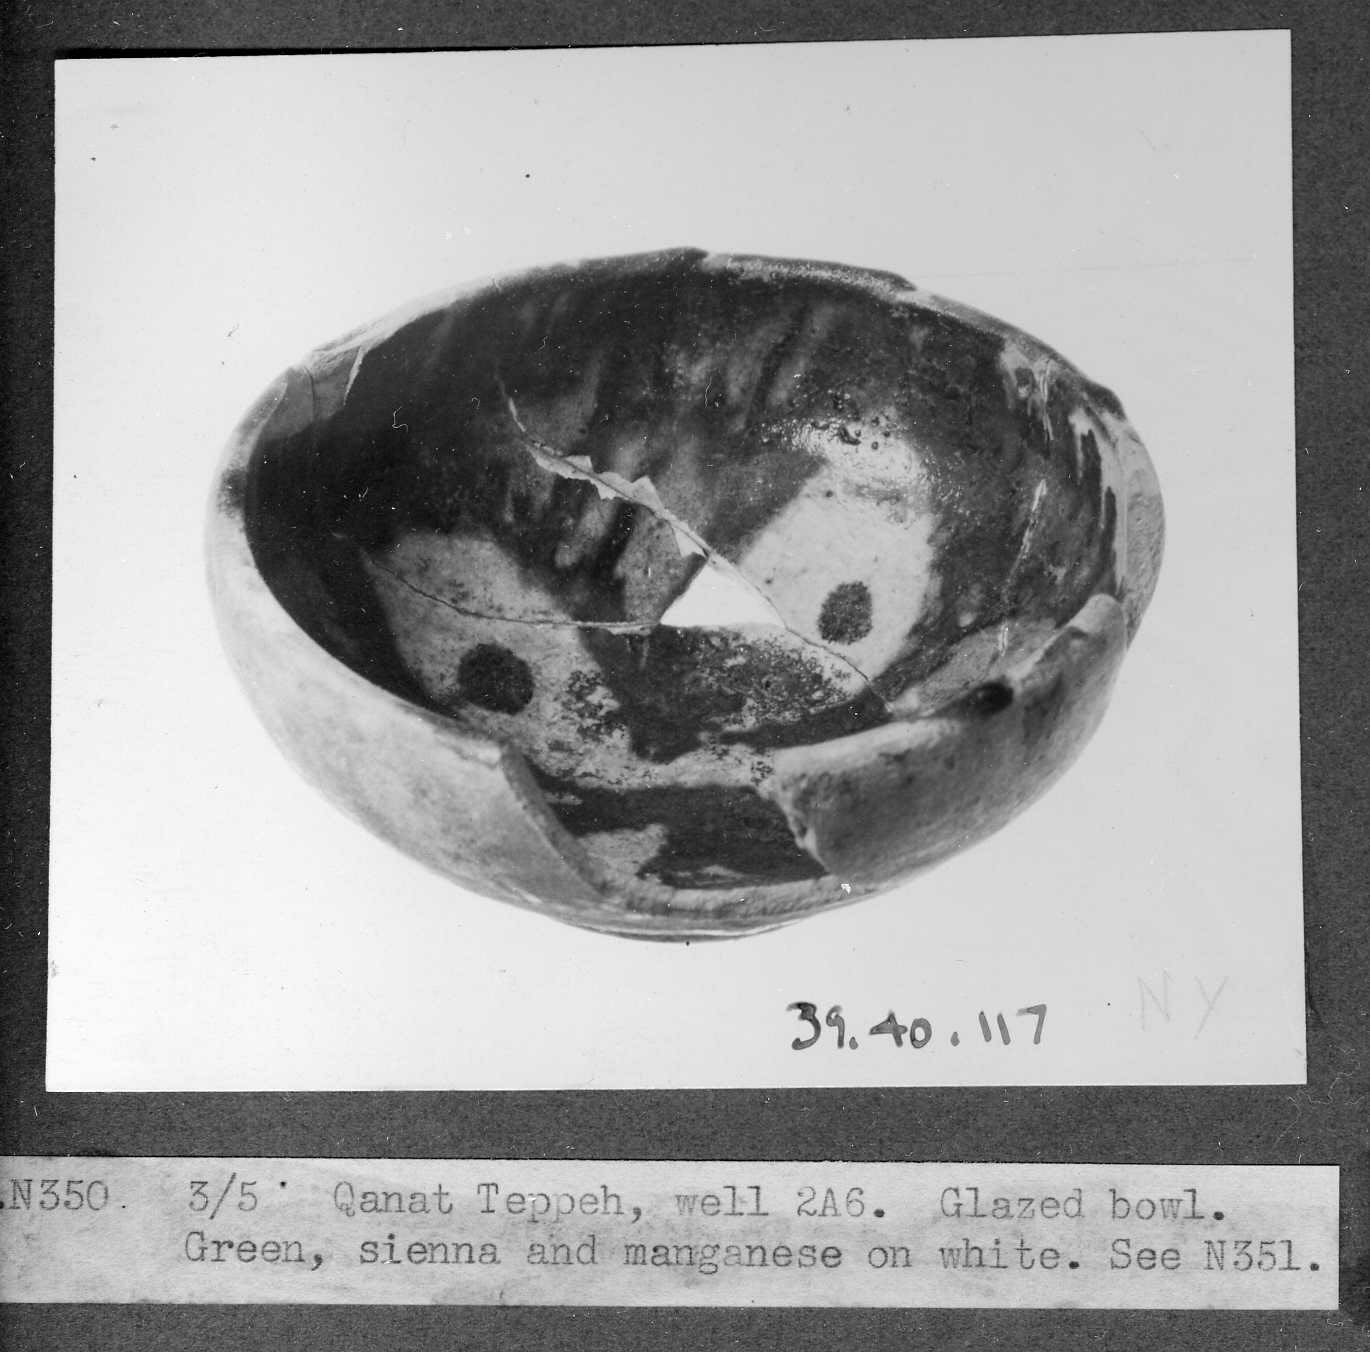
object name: bowl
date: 801-1000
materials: earthenware, glaze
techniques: painting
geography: iran